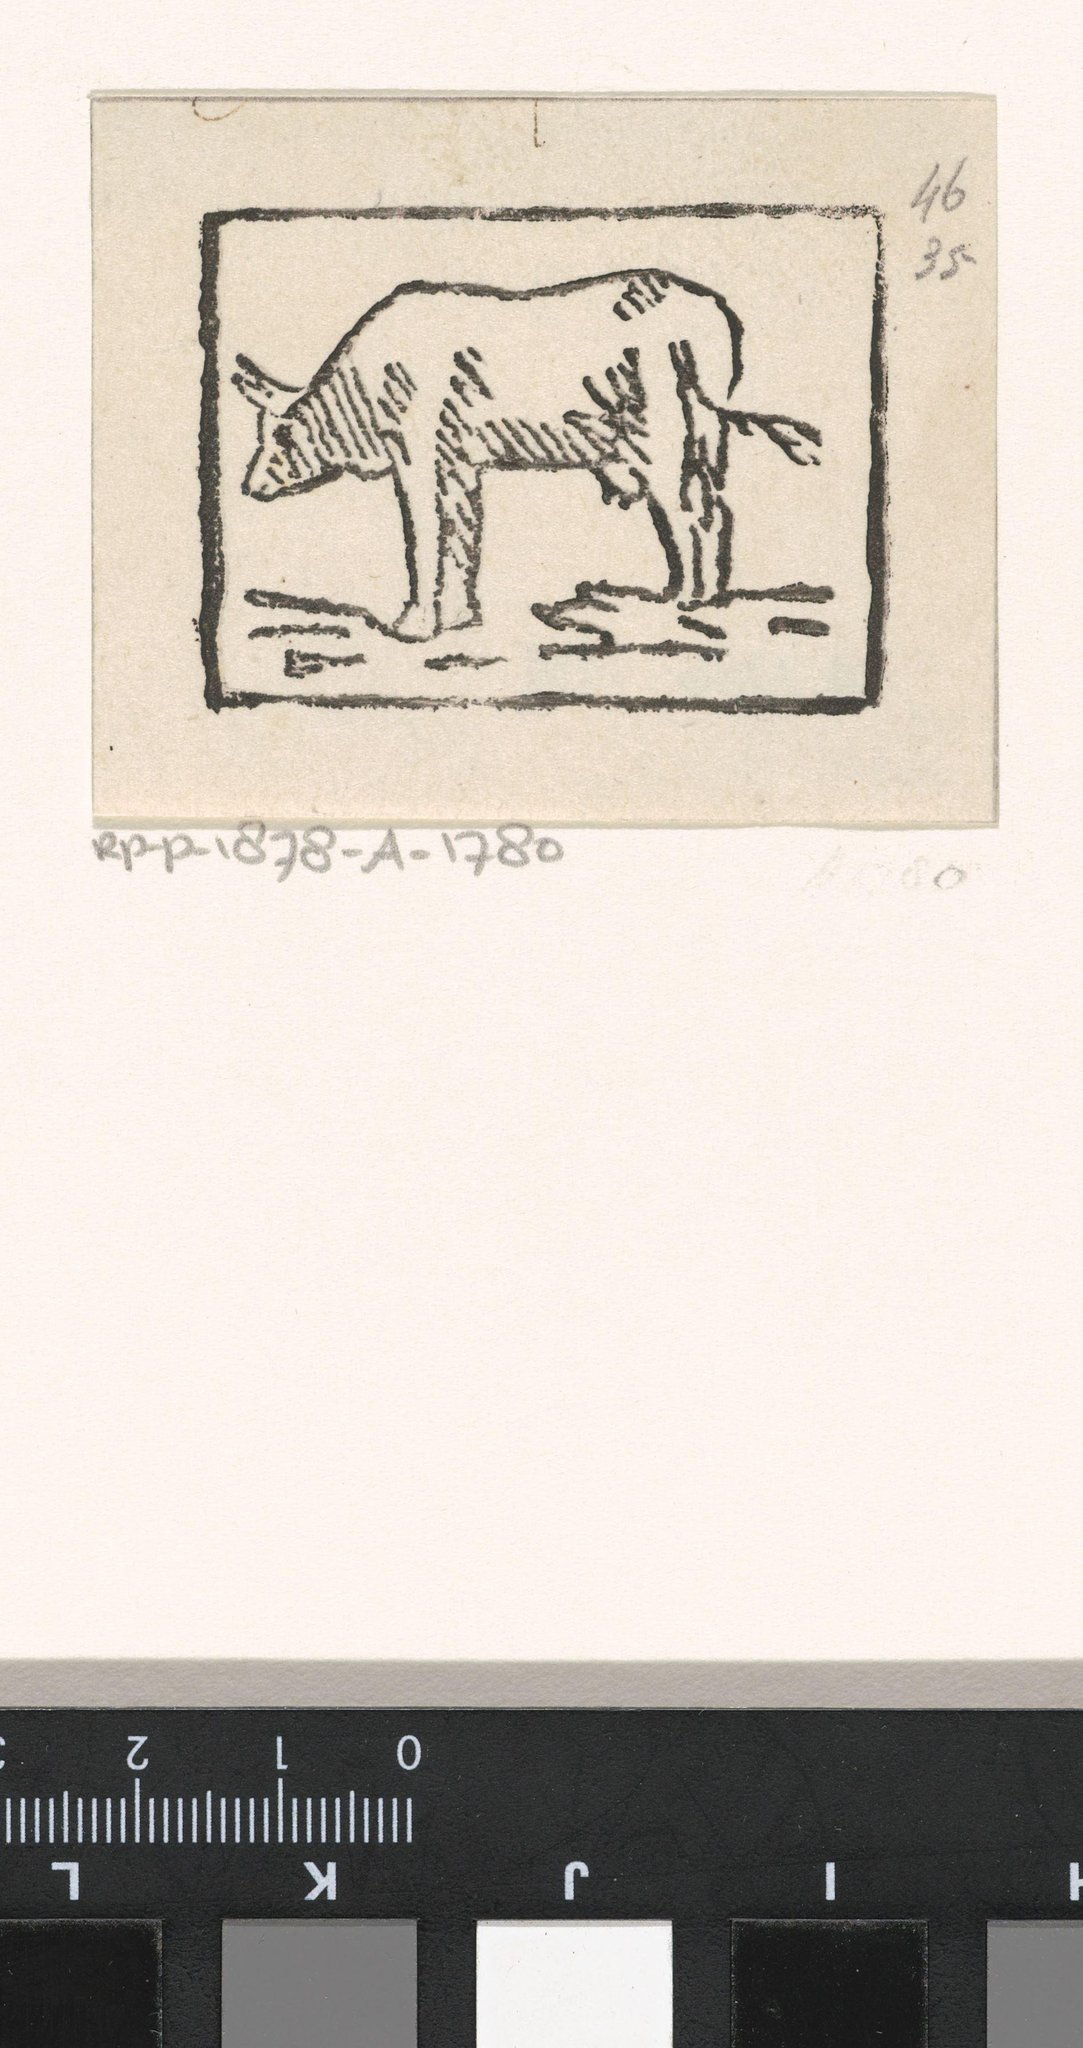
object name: print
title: Koe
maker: vincent van der vinne van lee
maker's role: print maker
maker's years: 1798-1876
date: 1808-1876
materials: paper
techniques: woodcut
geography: haarlem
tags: cow